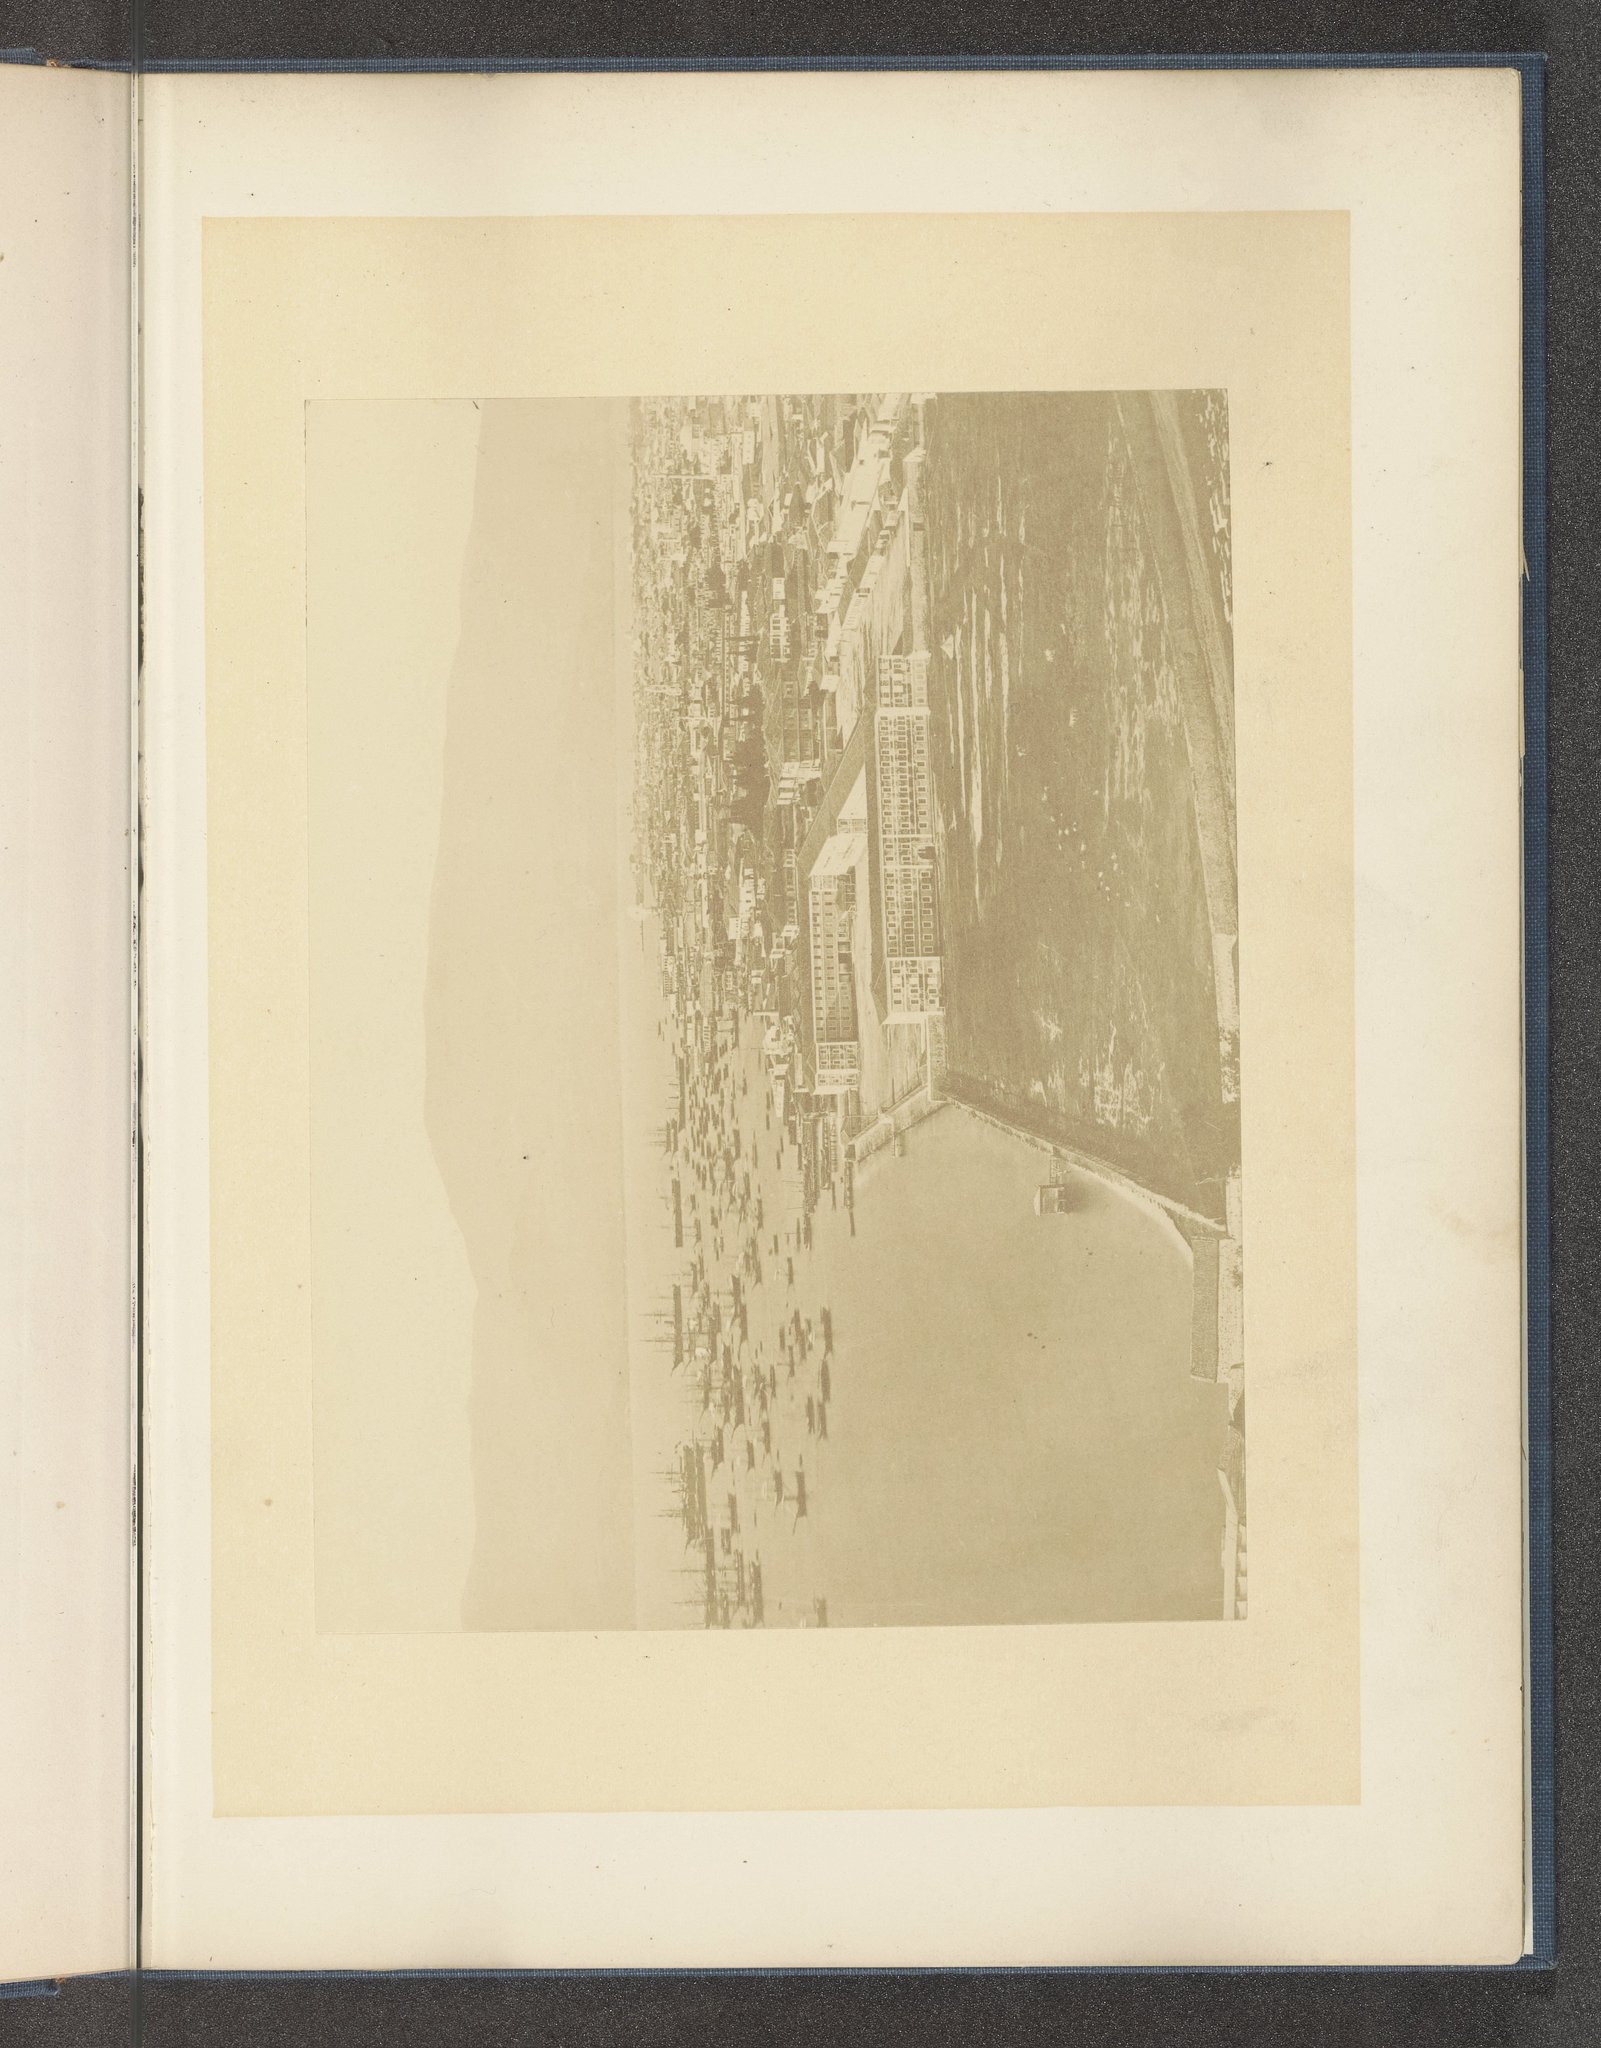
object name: photograph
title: Gezicht op Smyrna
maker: alexander svoboda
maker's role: fotograaf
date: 1859-1869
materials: photographic support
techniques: albumen print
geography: smyrna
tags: harbour, city-view in general; 'veduta'